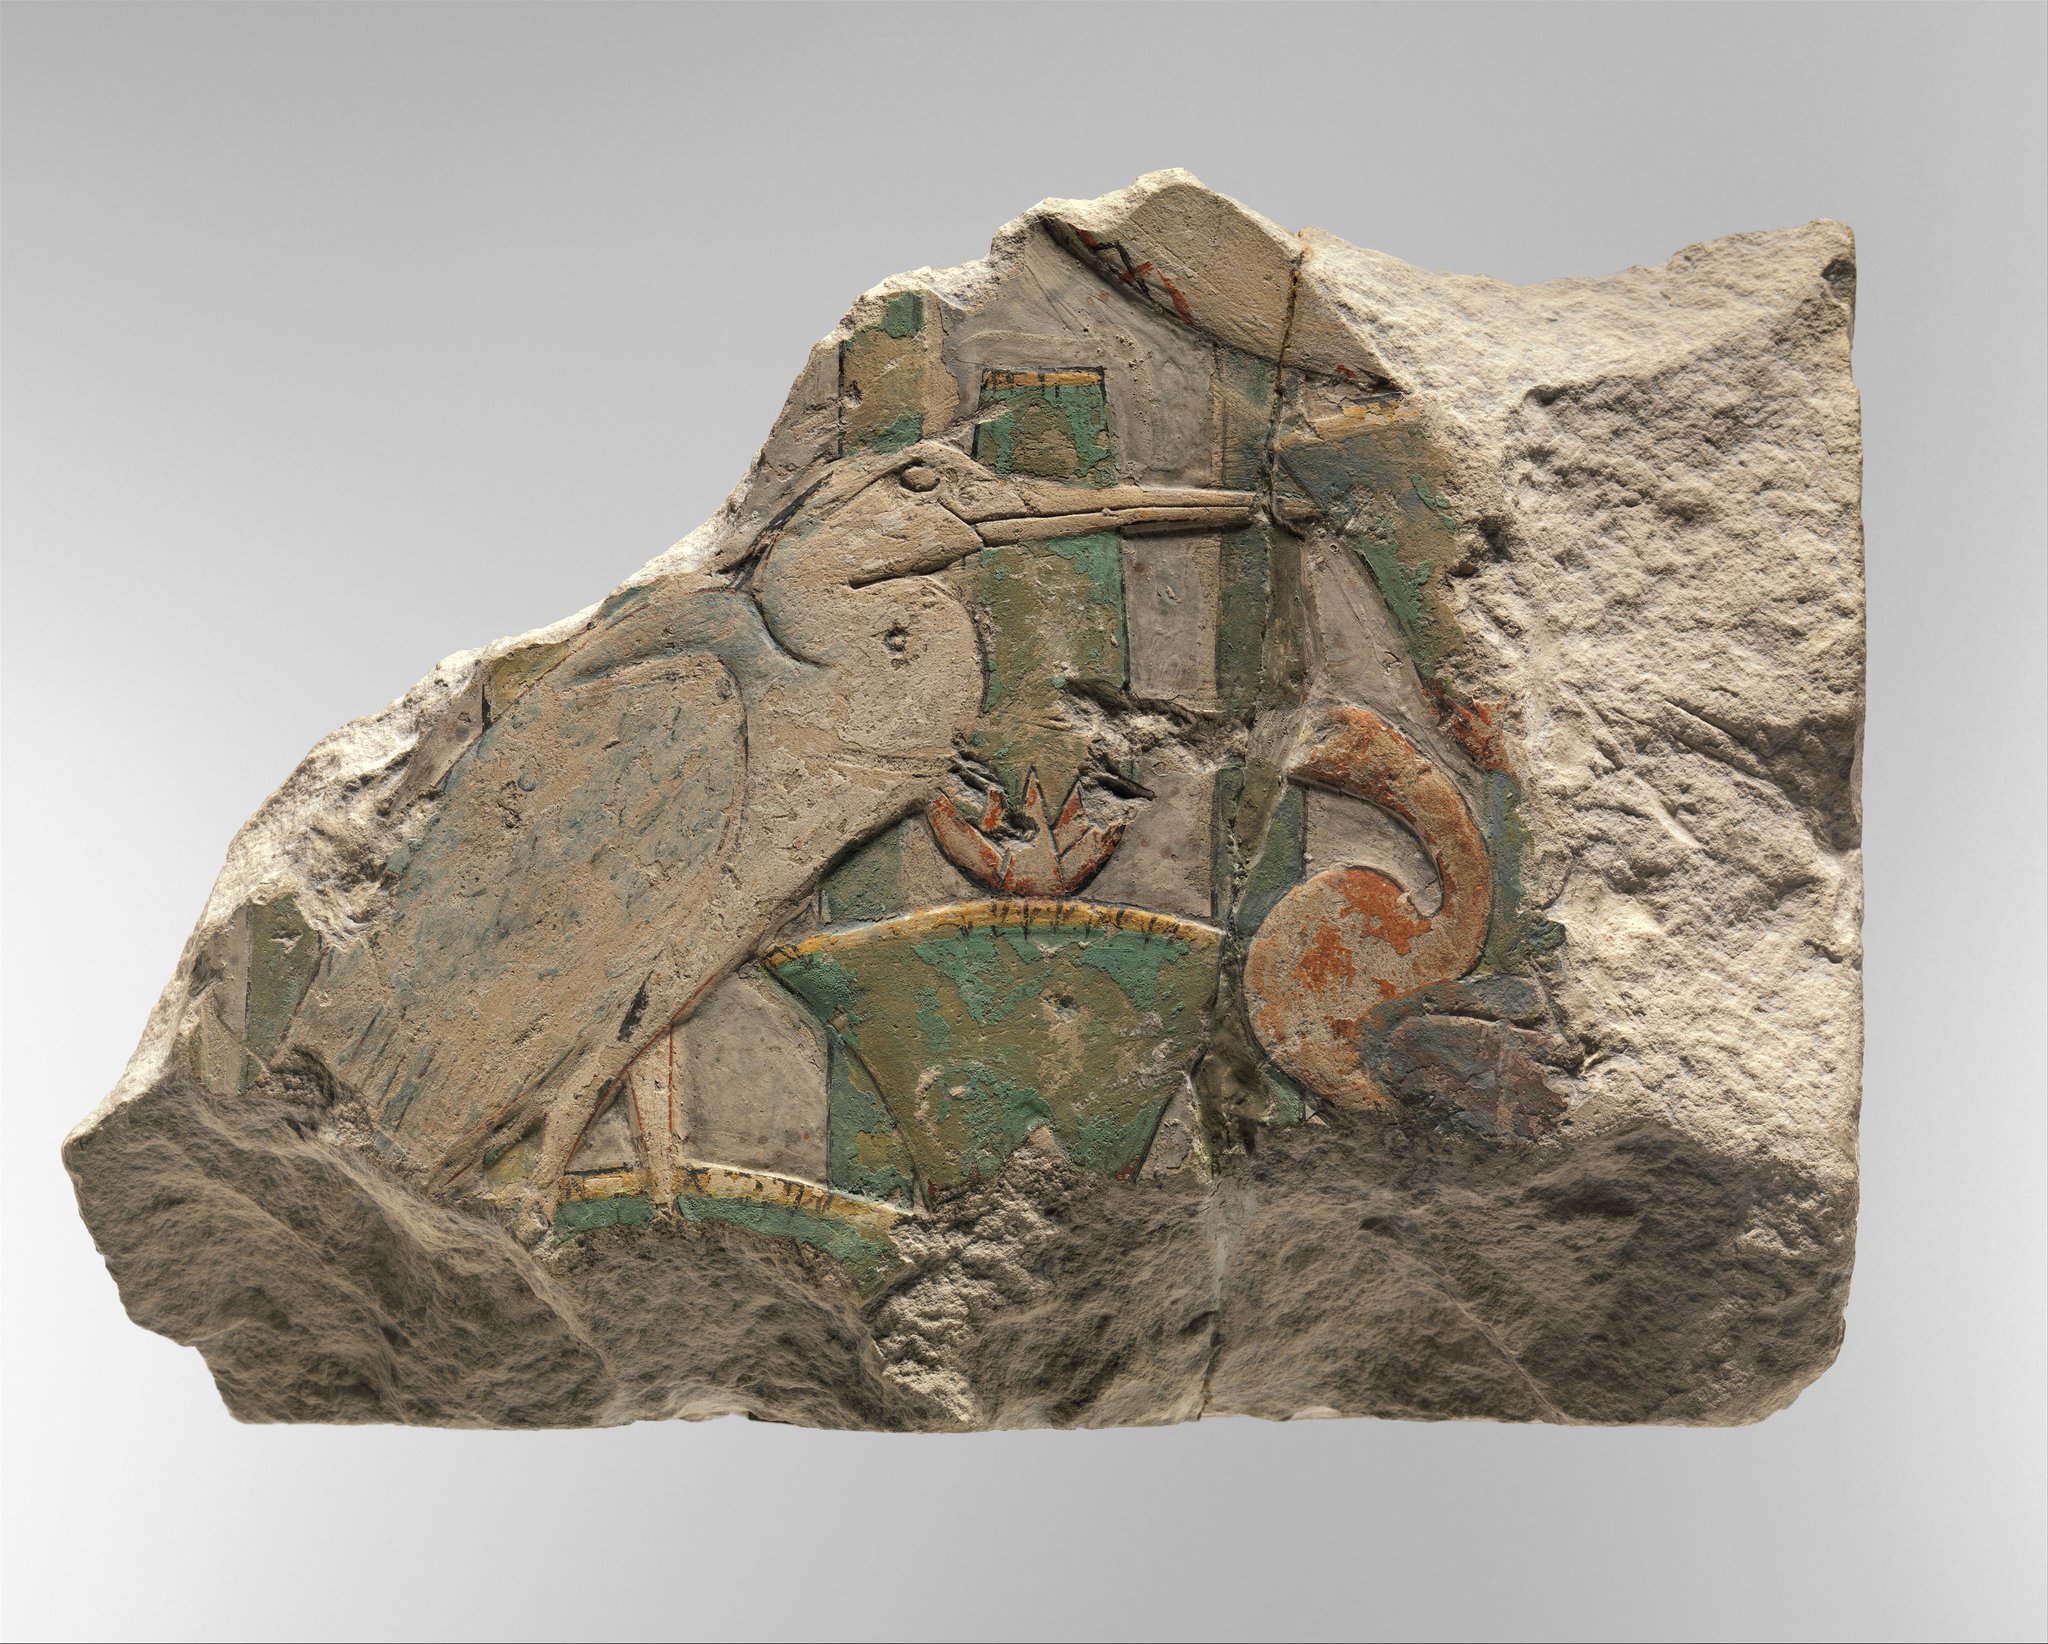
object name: relief, bird, papyrus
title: Relief Fragment with Two Birds in the Papyrus Thicket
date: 1925-1900 BCE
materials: limestone, paint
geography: egypt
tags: birds